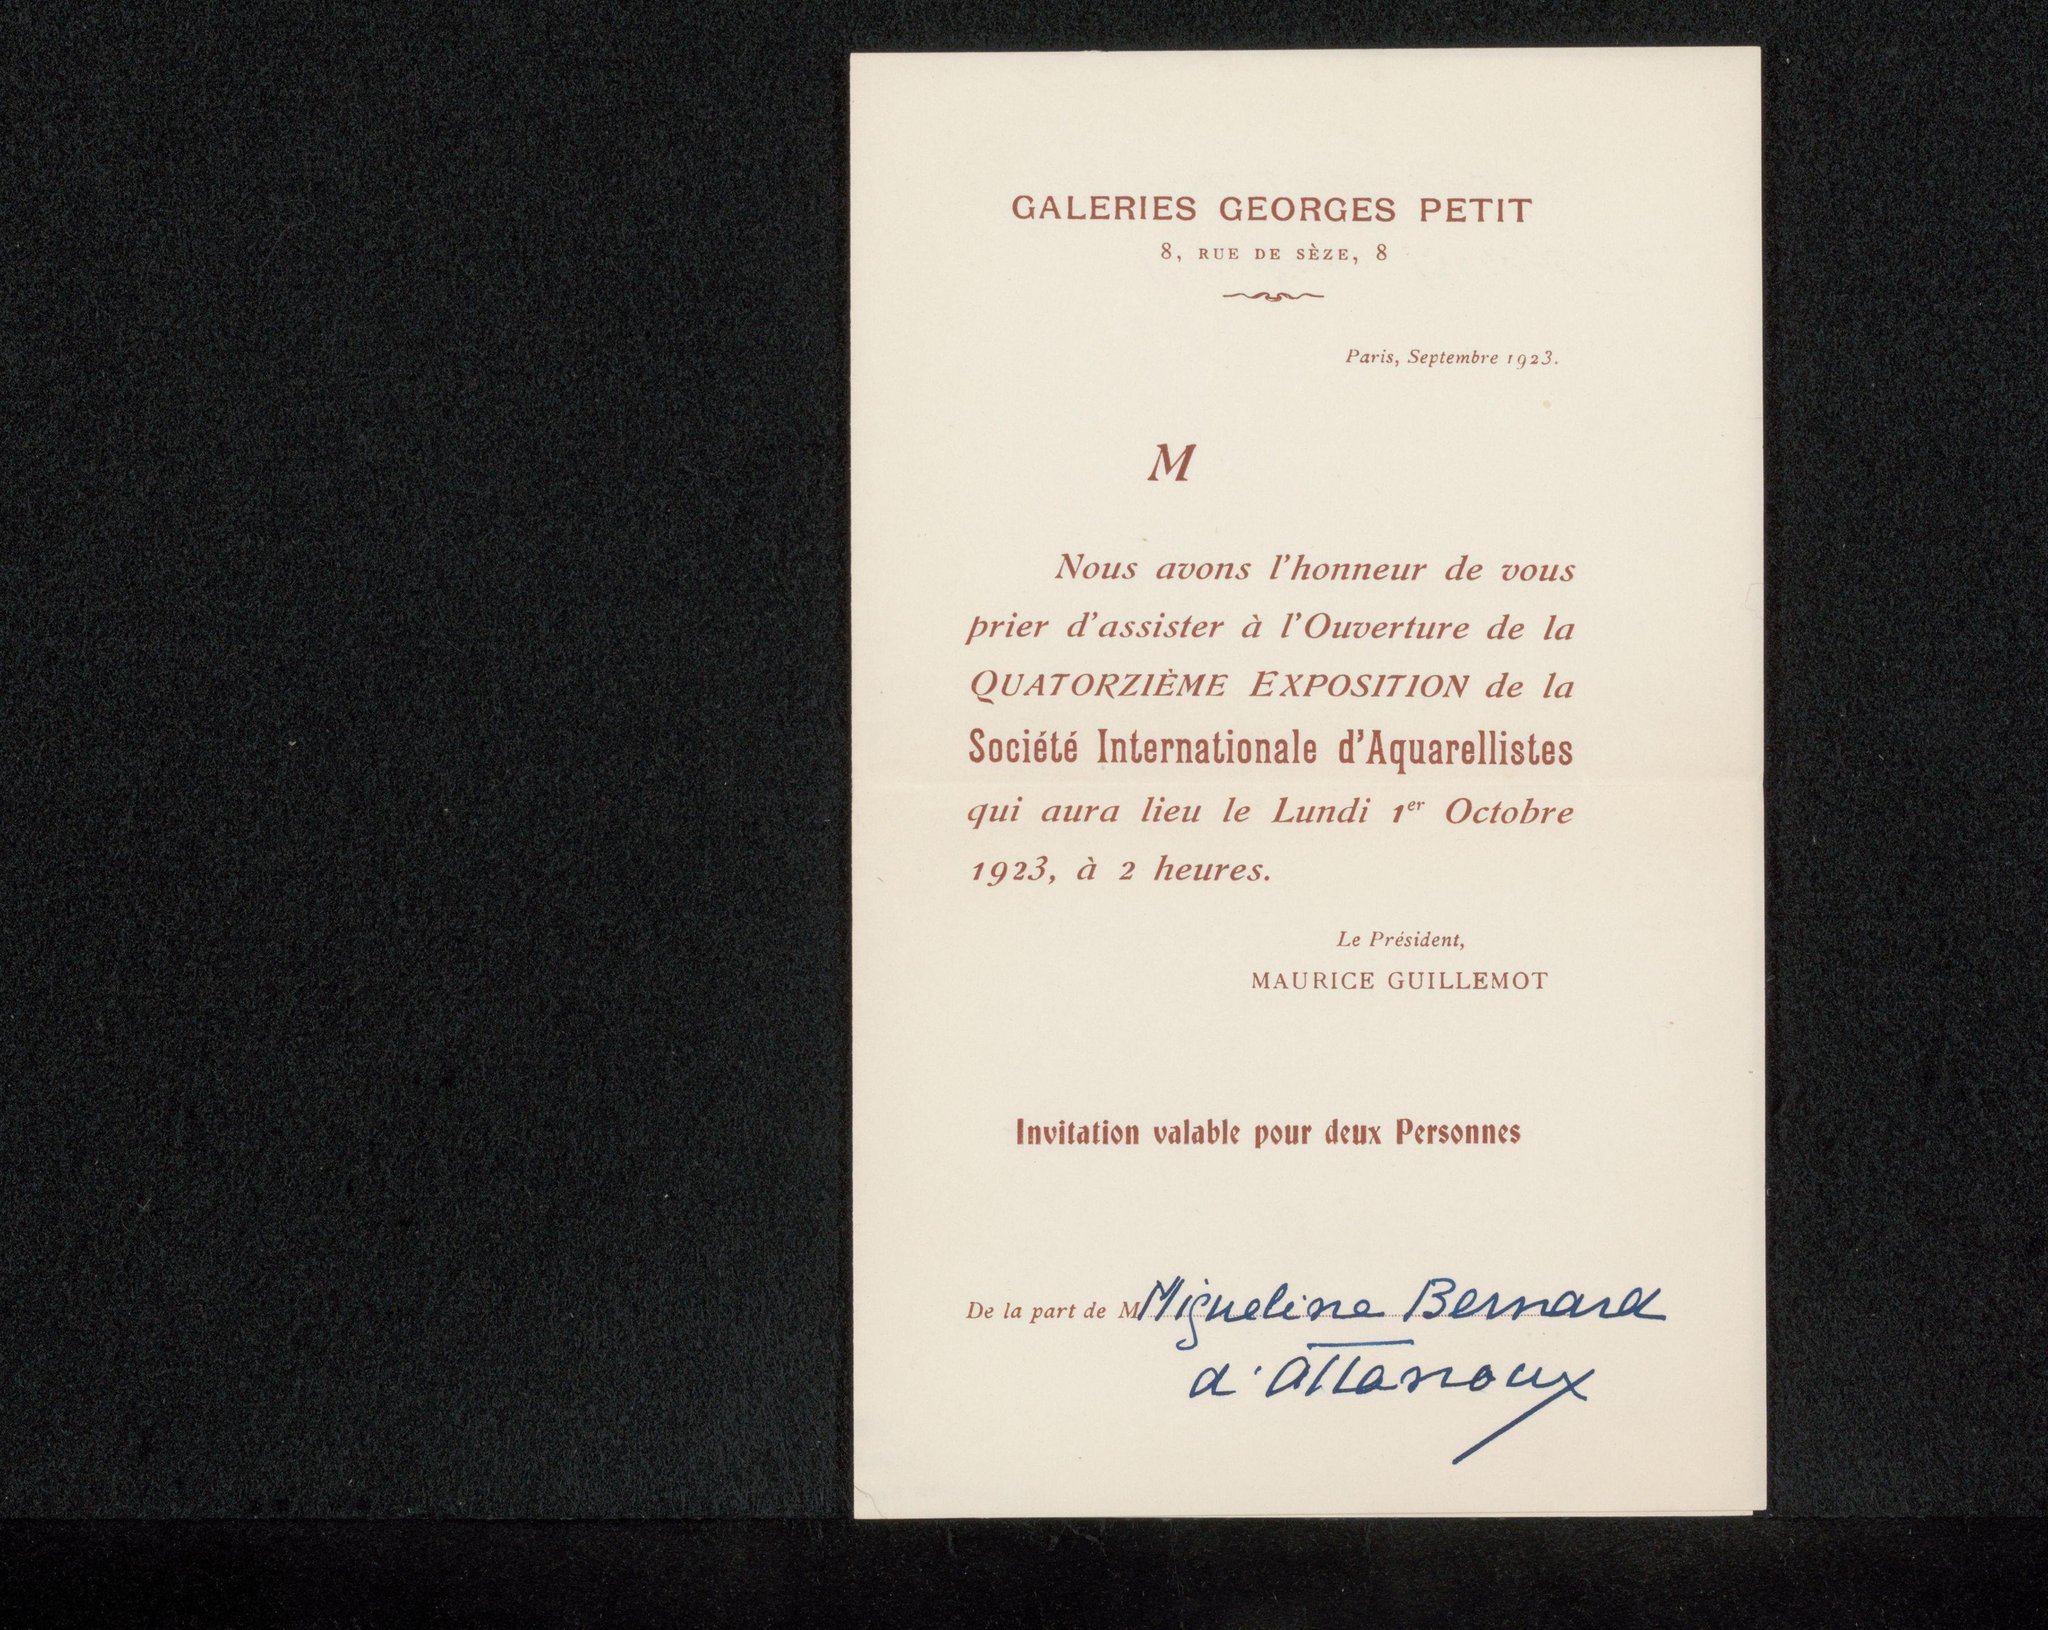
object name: invitation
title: Uitnodiging aan Philip Zilcken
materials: ink, paper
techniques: pen, printing, writing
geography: paris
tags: the hague, painter, draughtsman, philip zilcken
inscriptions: collector's mark: ‘RPK’